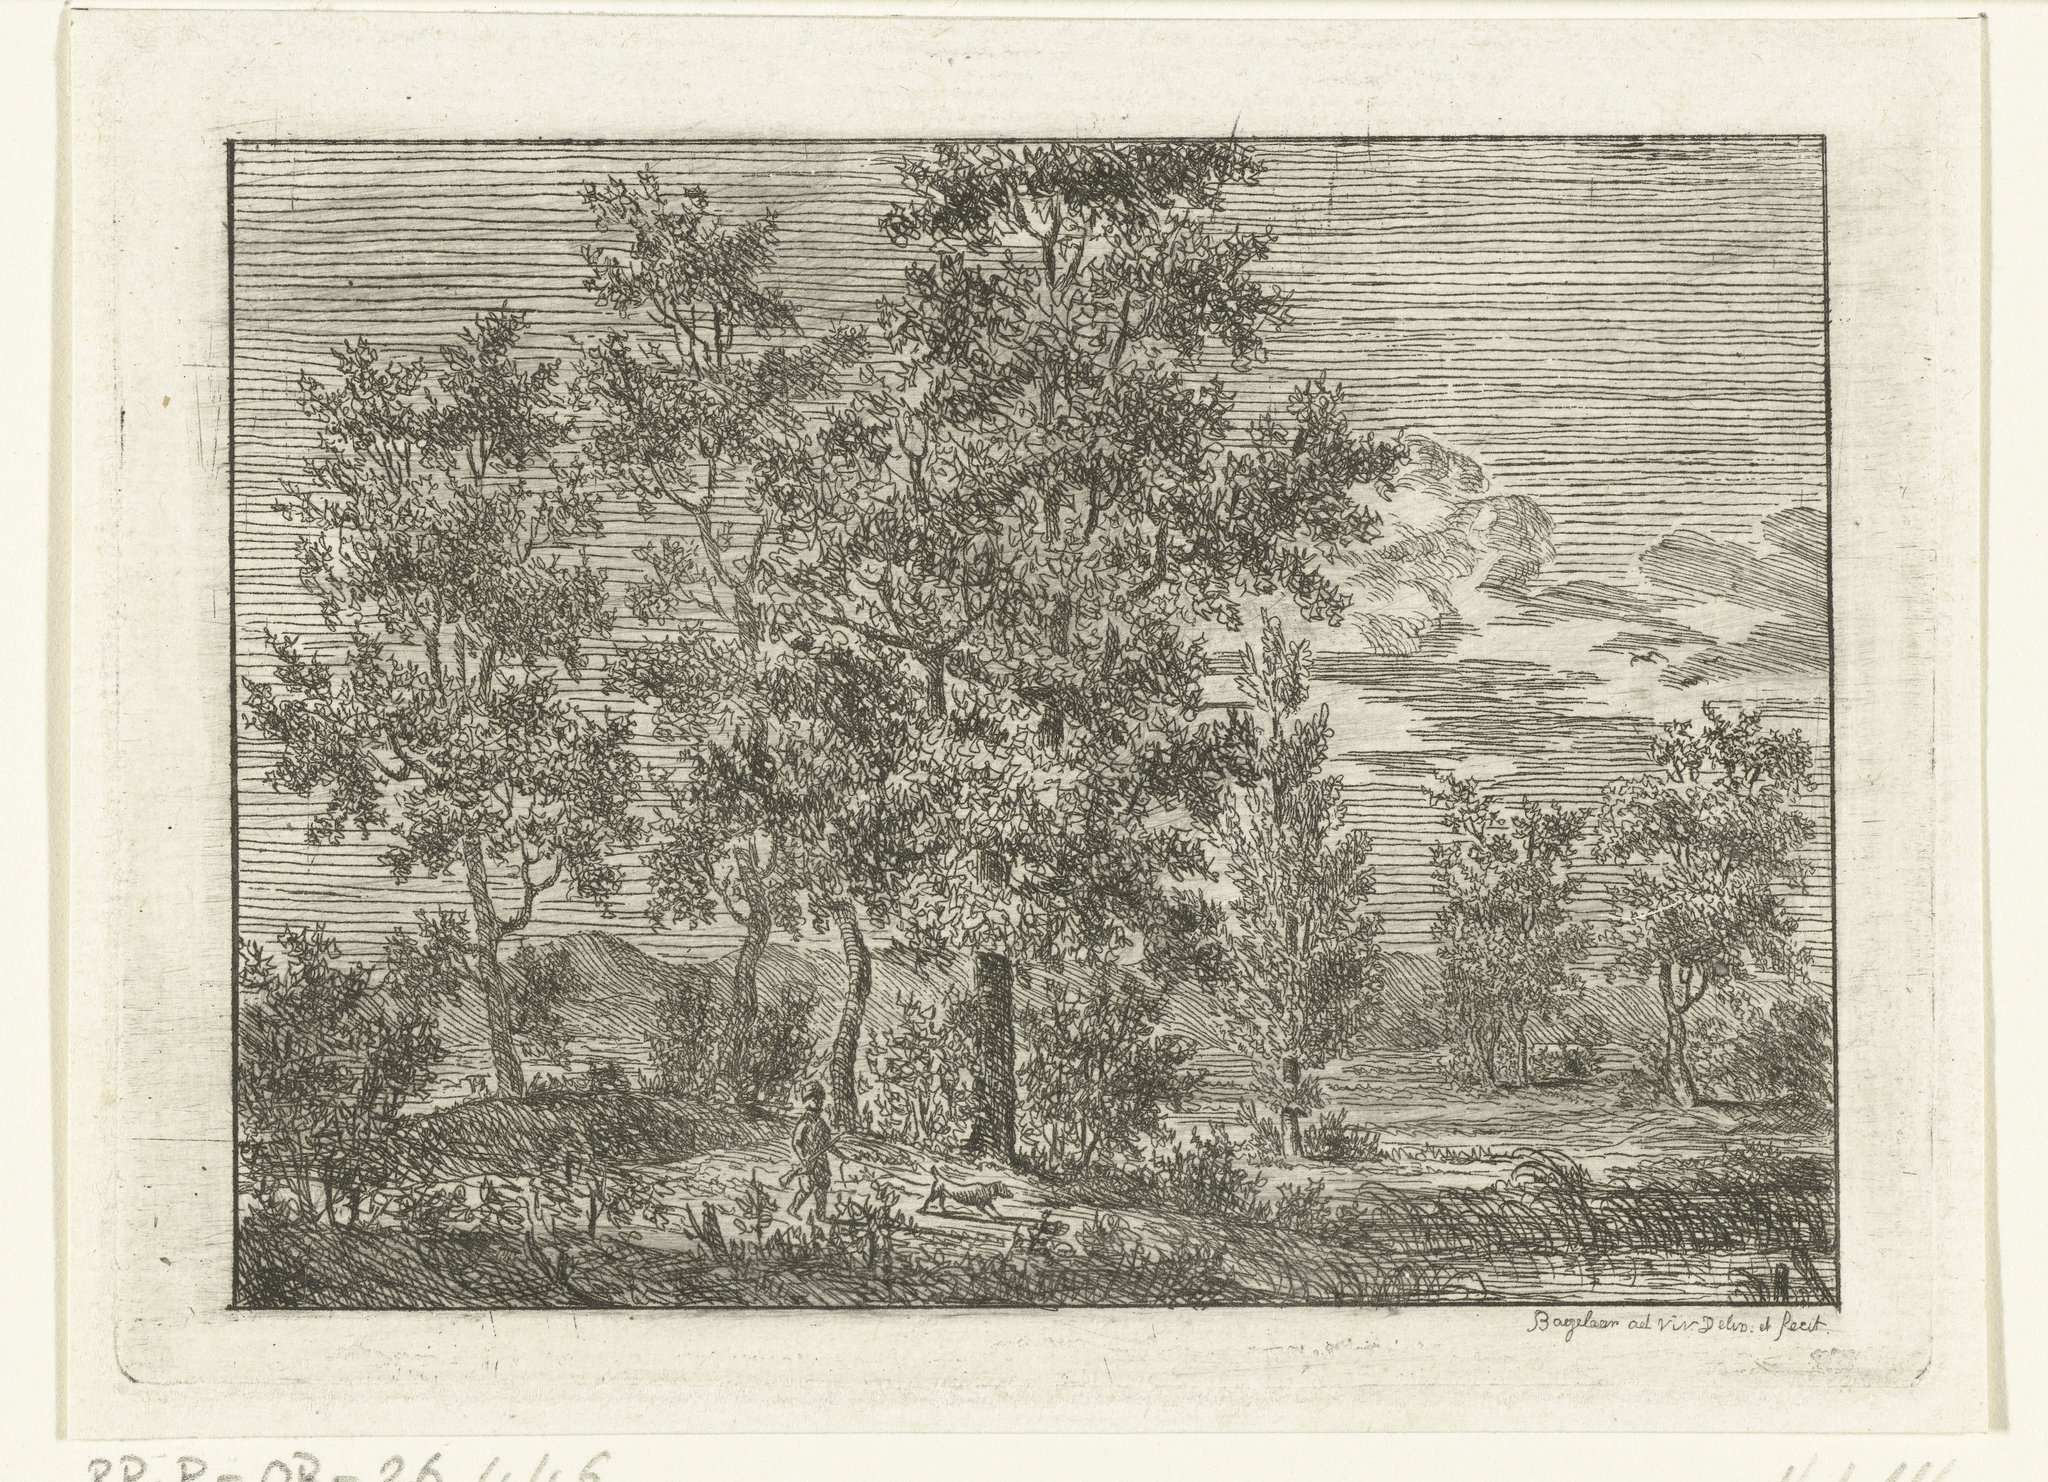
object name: print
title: Landschap met jager en hond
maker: ernst willem jan bagelaar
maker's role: draughtsman, print maker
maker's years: 1775-1837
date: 1798-1837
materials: paper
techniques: drypoint, etching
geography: netherlands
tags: landscapes in the temperate zone (+ landscape with figures, staffage)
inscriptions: collector's mark: Lugt 2228